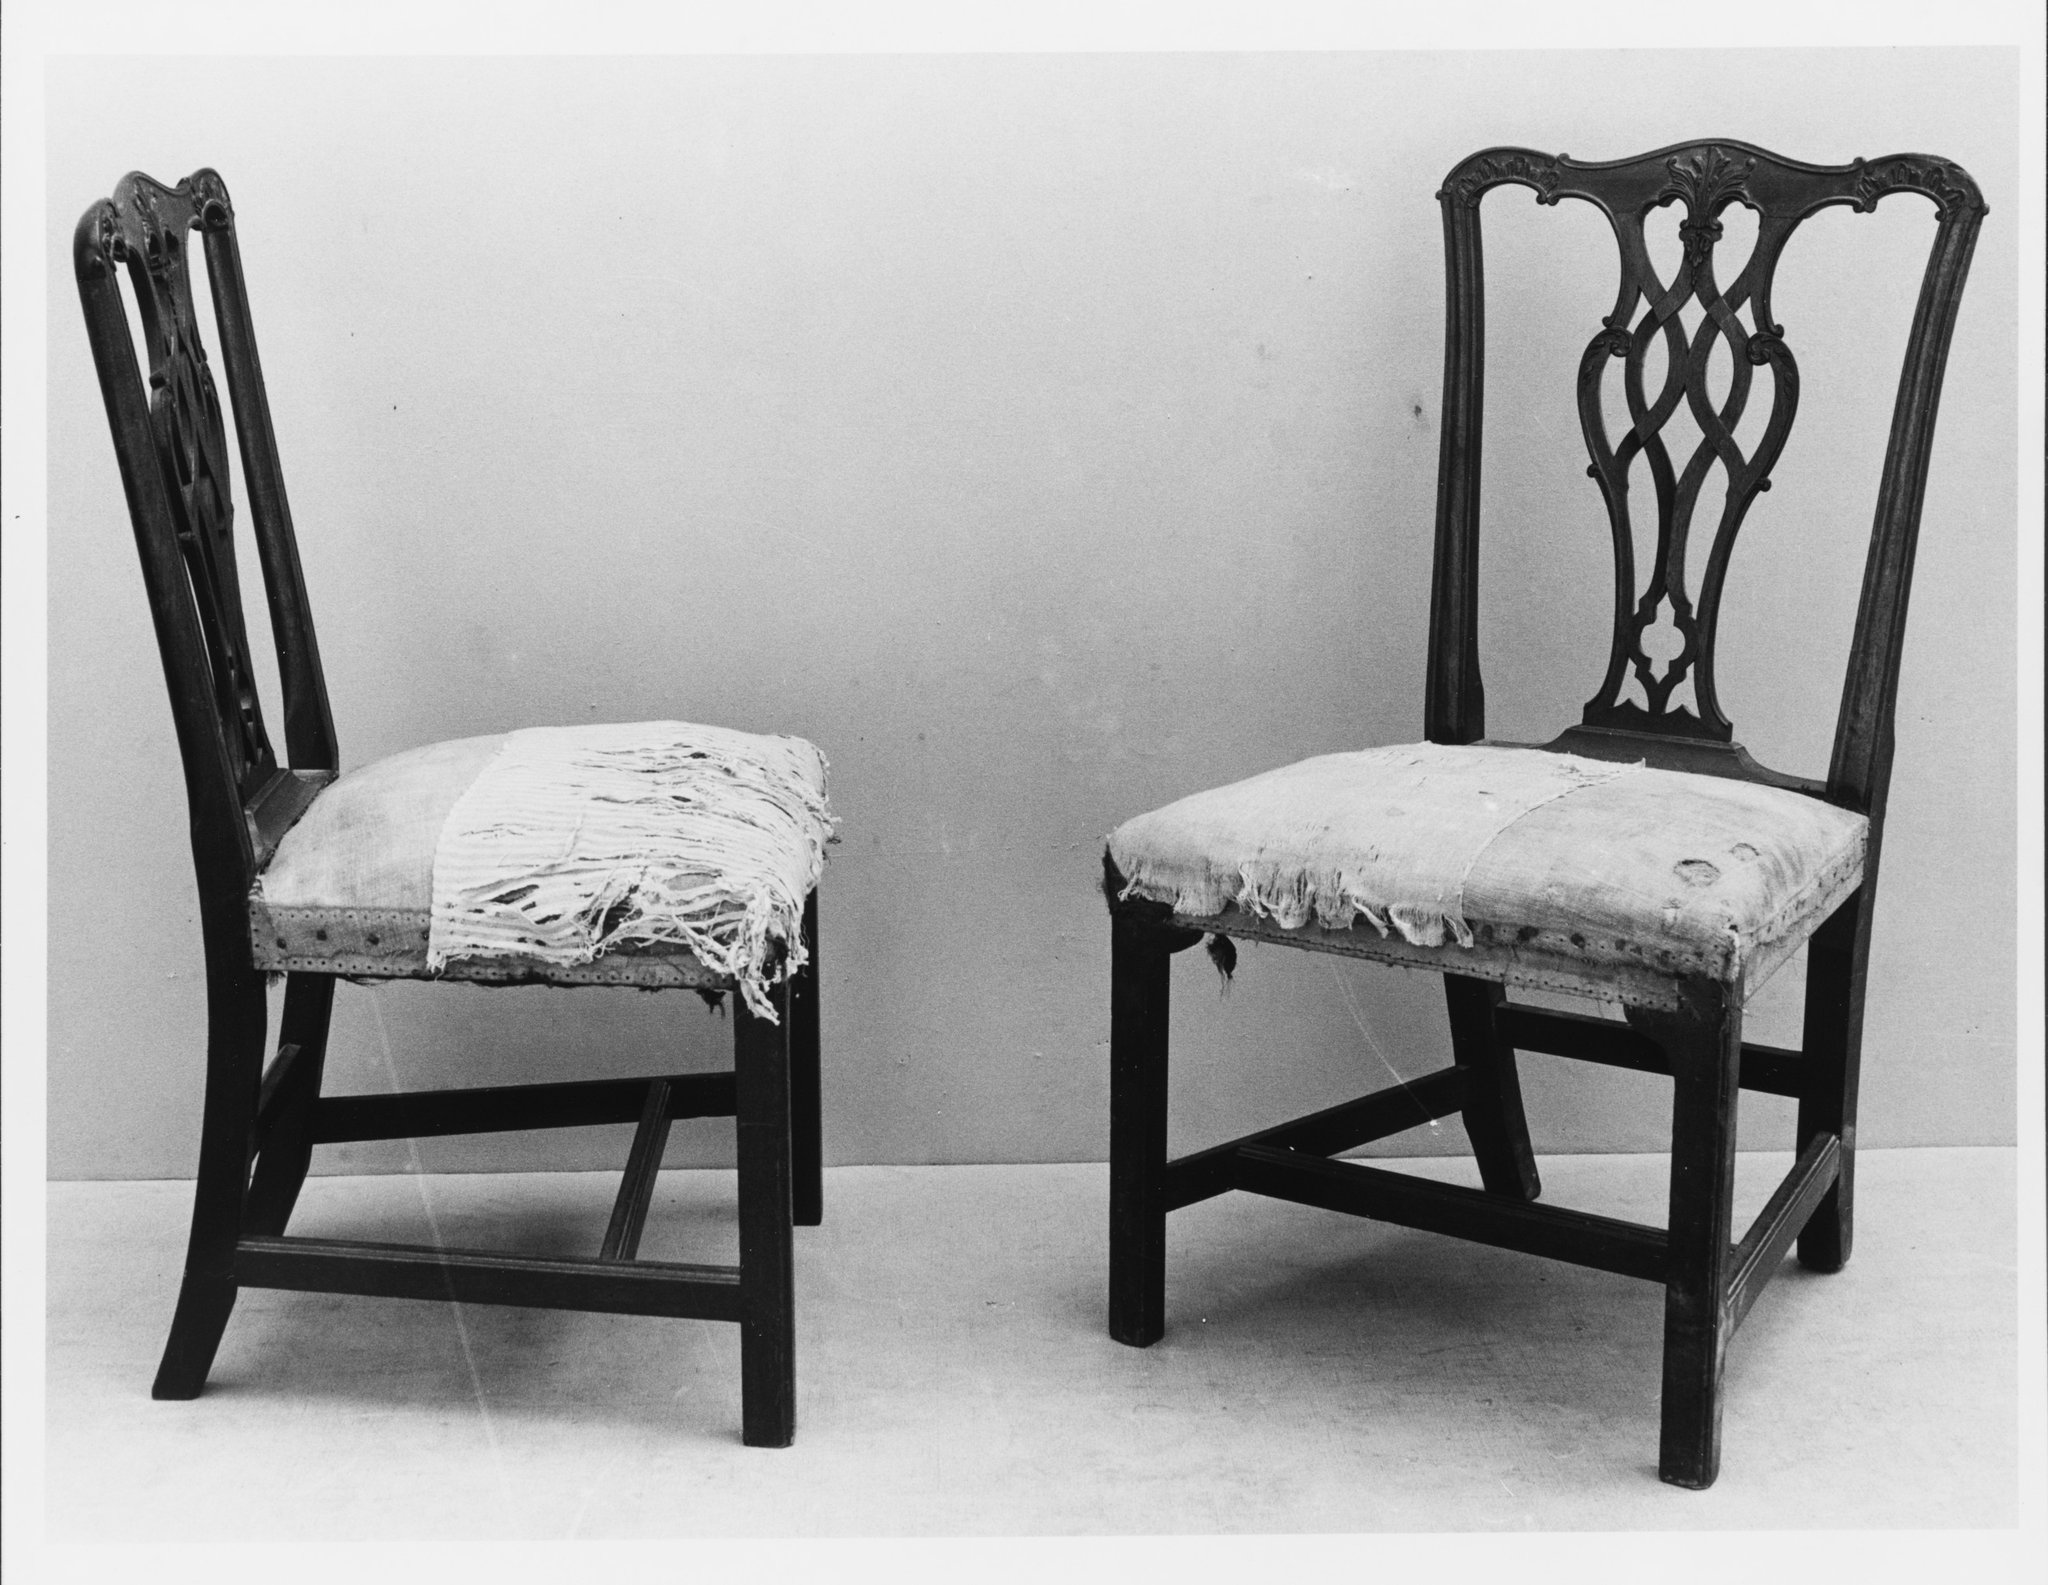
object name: side chair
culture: american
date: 1760-1790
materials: wood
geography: united states